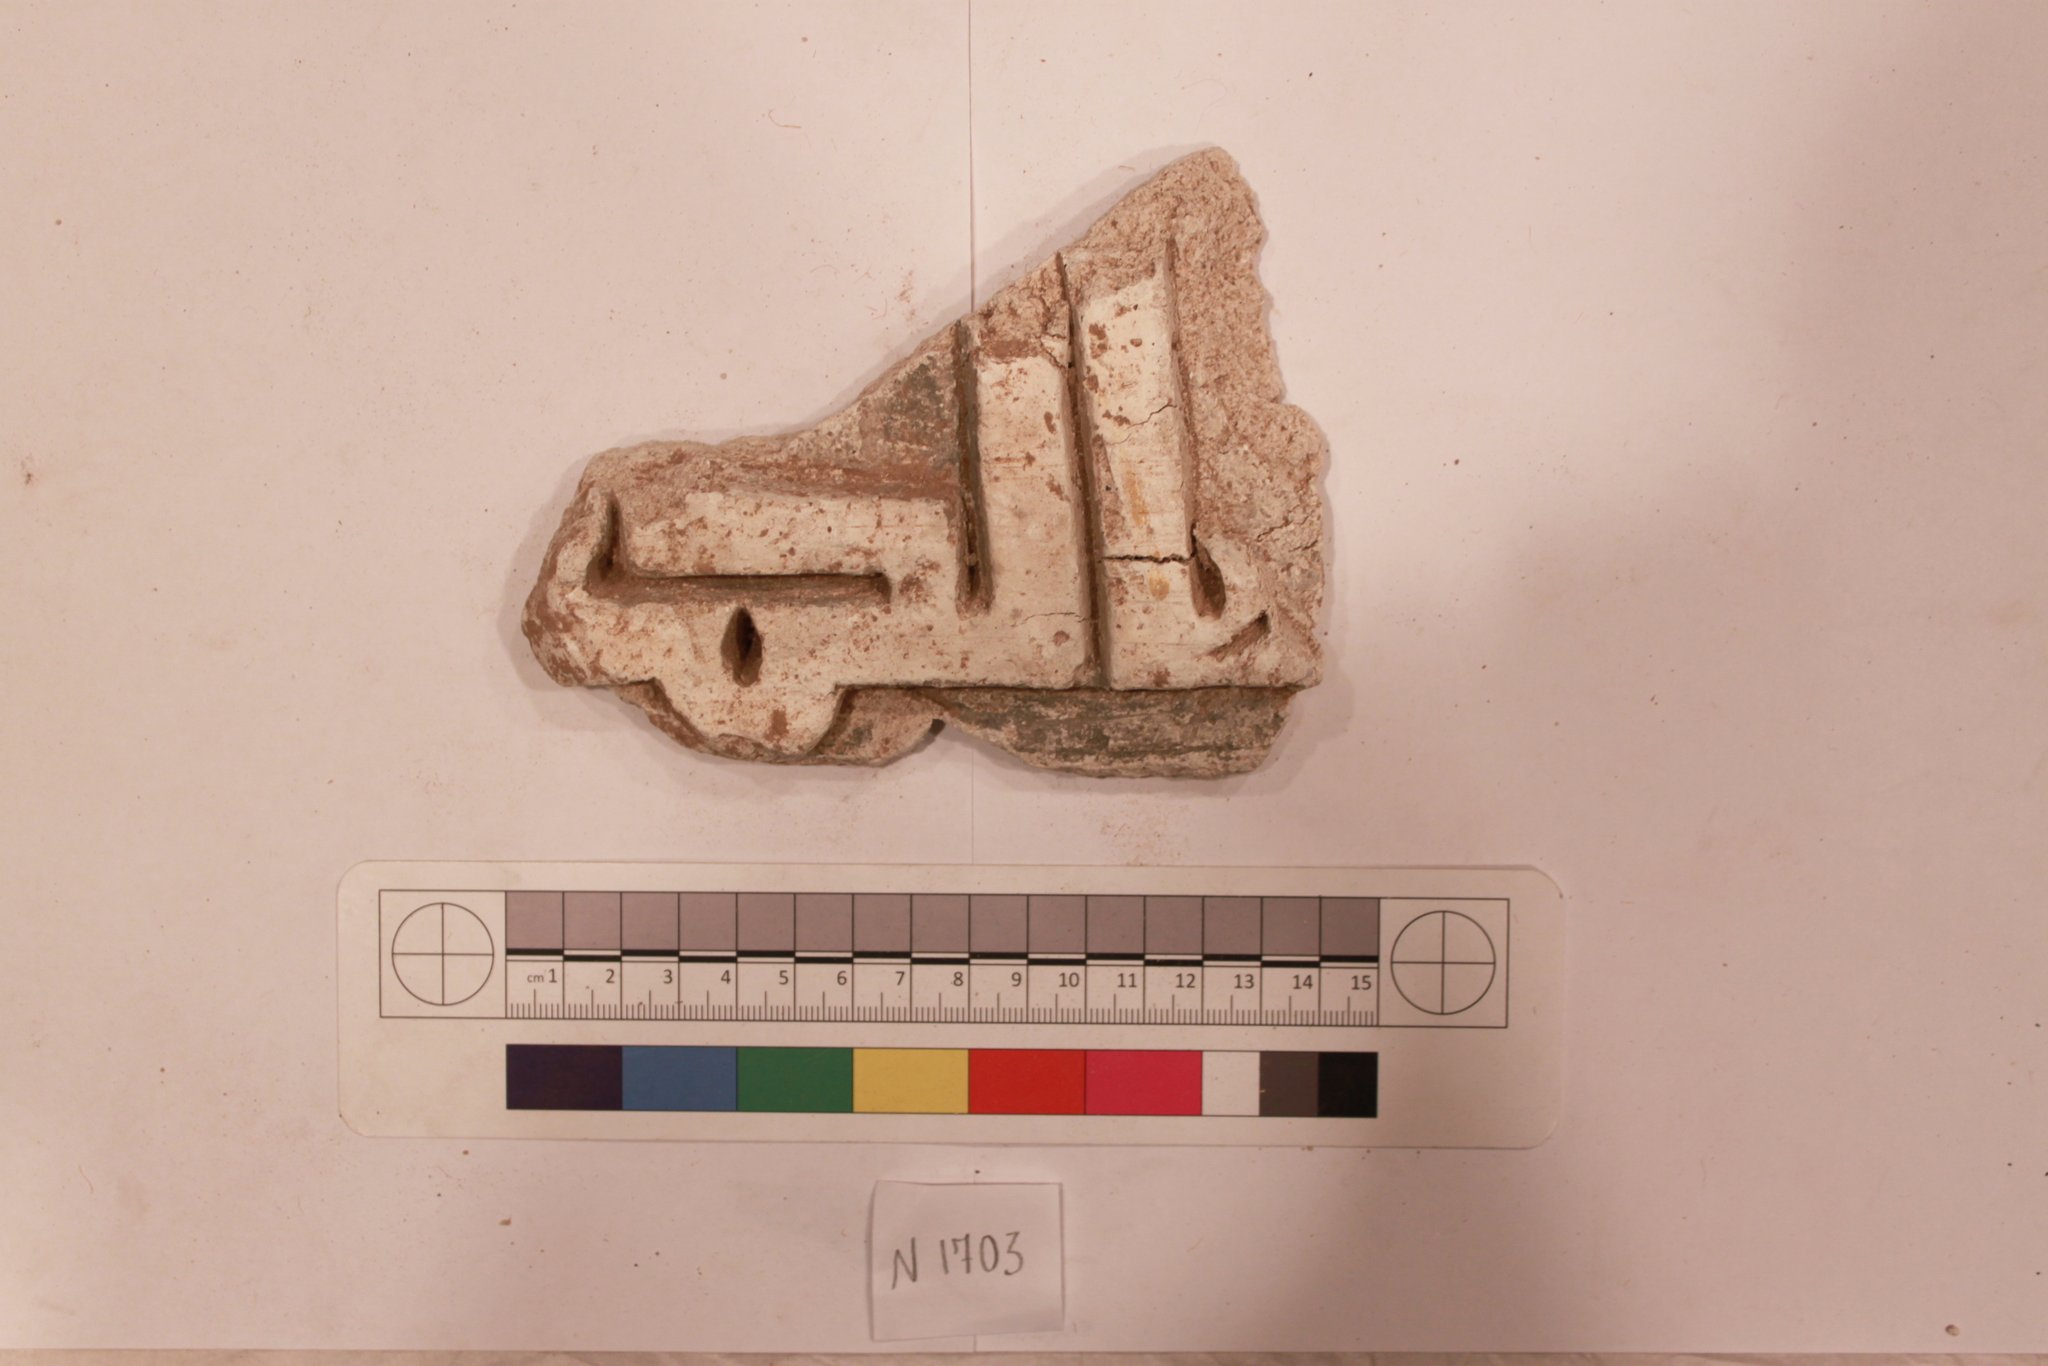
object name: fragment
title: Stucco Fragment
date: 701-1200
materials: plaster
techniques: carving, painting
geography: iran